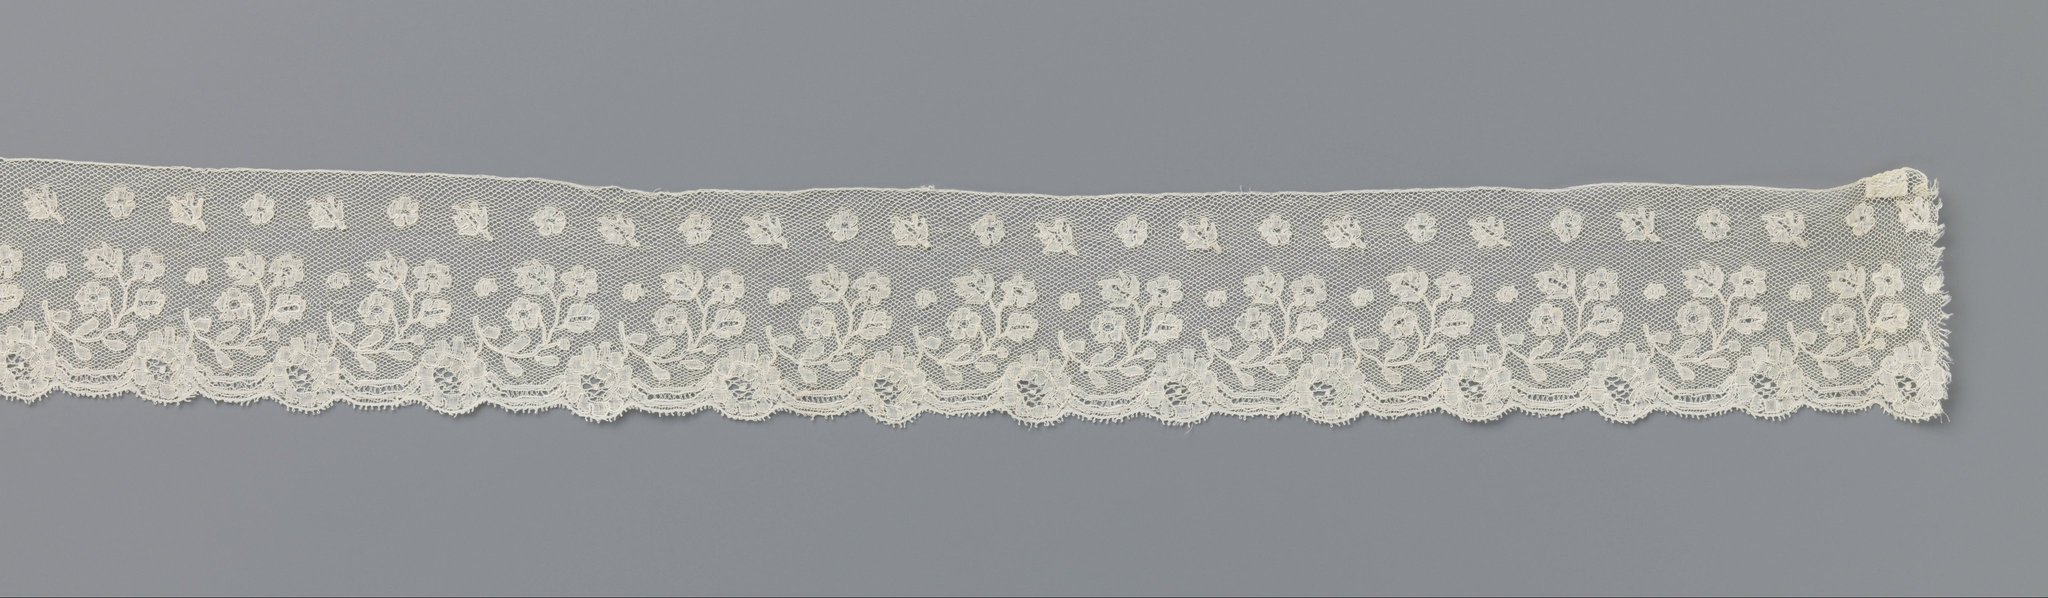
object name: strip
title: Strook kloskant met hangende roos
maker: Anonymous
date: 1900-1924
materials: linen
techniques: lace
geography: turnhout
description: Op de traliegrond, een Mechelse grond (ook wel ijsgrond genoemd), staat onder een stijve rij van bladeren en bloemen een rij van dubbele takjes, met aan een opstaande tak kleine bloempjes en blaadjes en aan een zijtak een afhangende roos. De laatste vormt met 'spoorrails' de schulpjes. Mechelse kant.